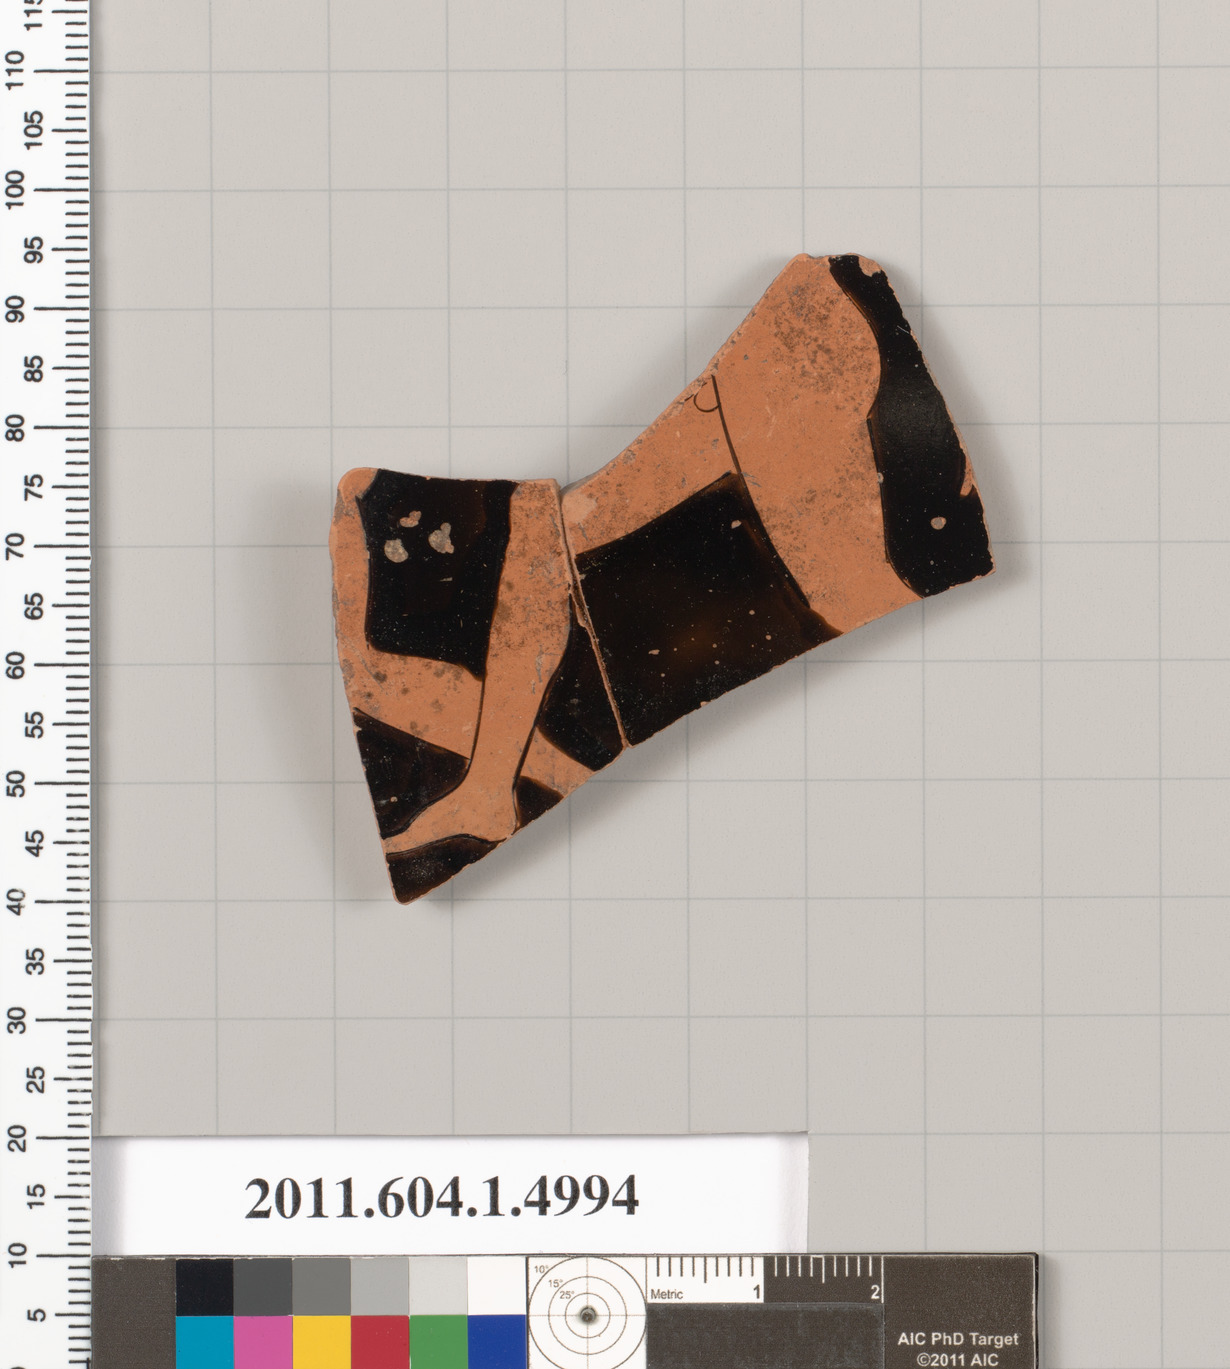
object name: kylix fragment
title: Terracotta fragment of a kylix (drinking cup)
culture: greek, attic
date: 500-480 BCE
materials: terracotta